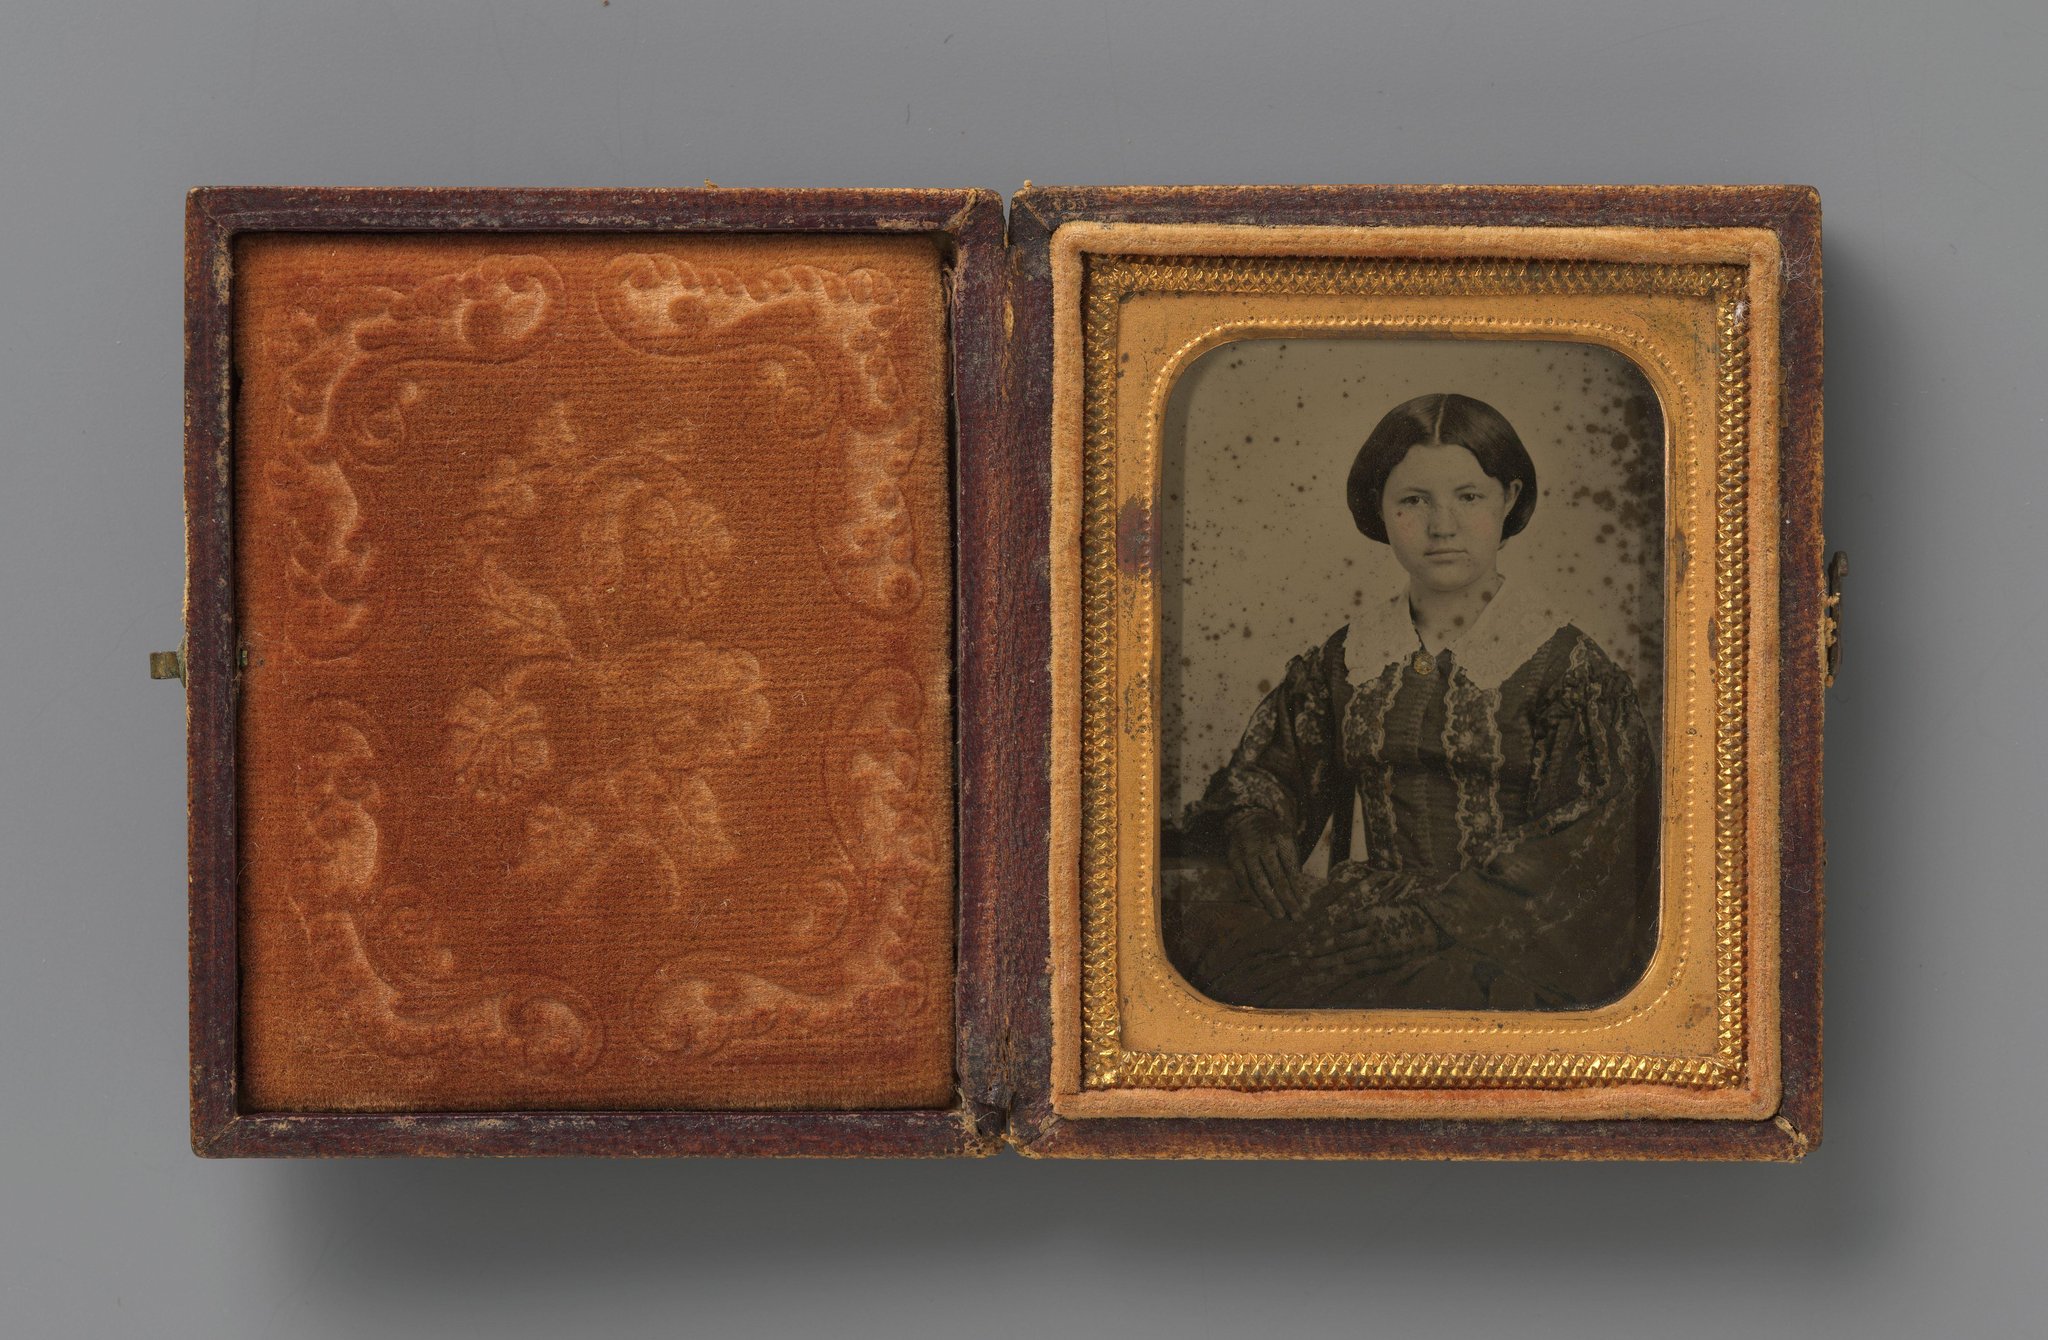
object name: photograph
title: Portret van onbekende (Amerikaanse) vrouw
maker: Anonymous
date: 1855-1860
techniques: ambrotype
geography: philadelphia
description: In etui samen met een portret van Weduwe van Andel-van Schendel (Haarlem).